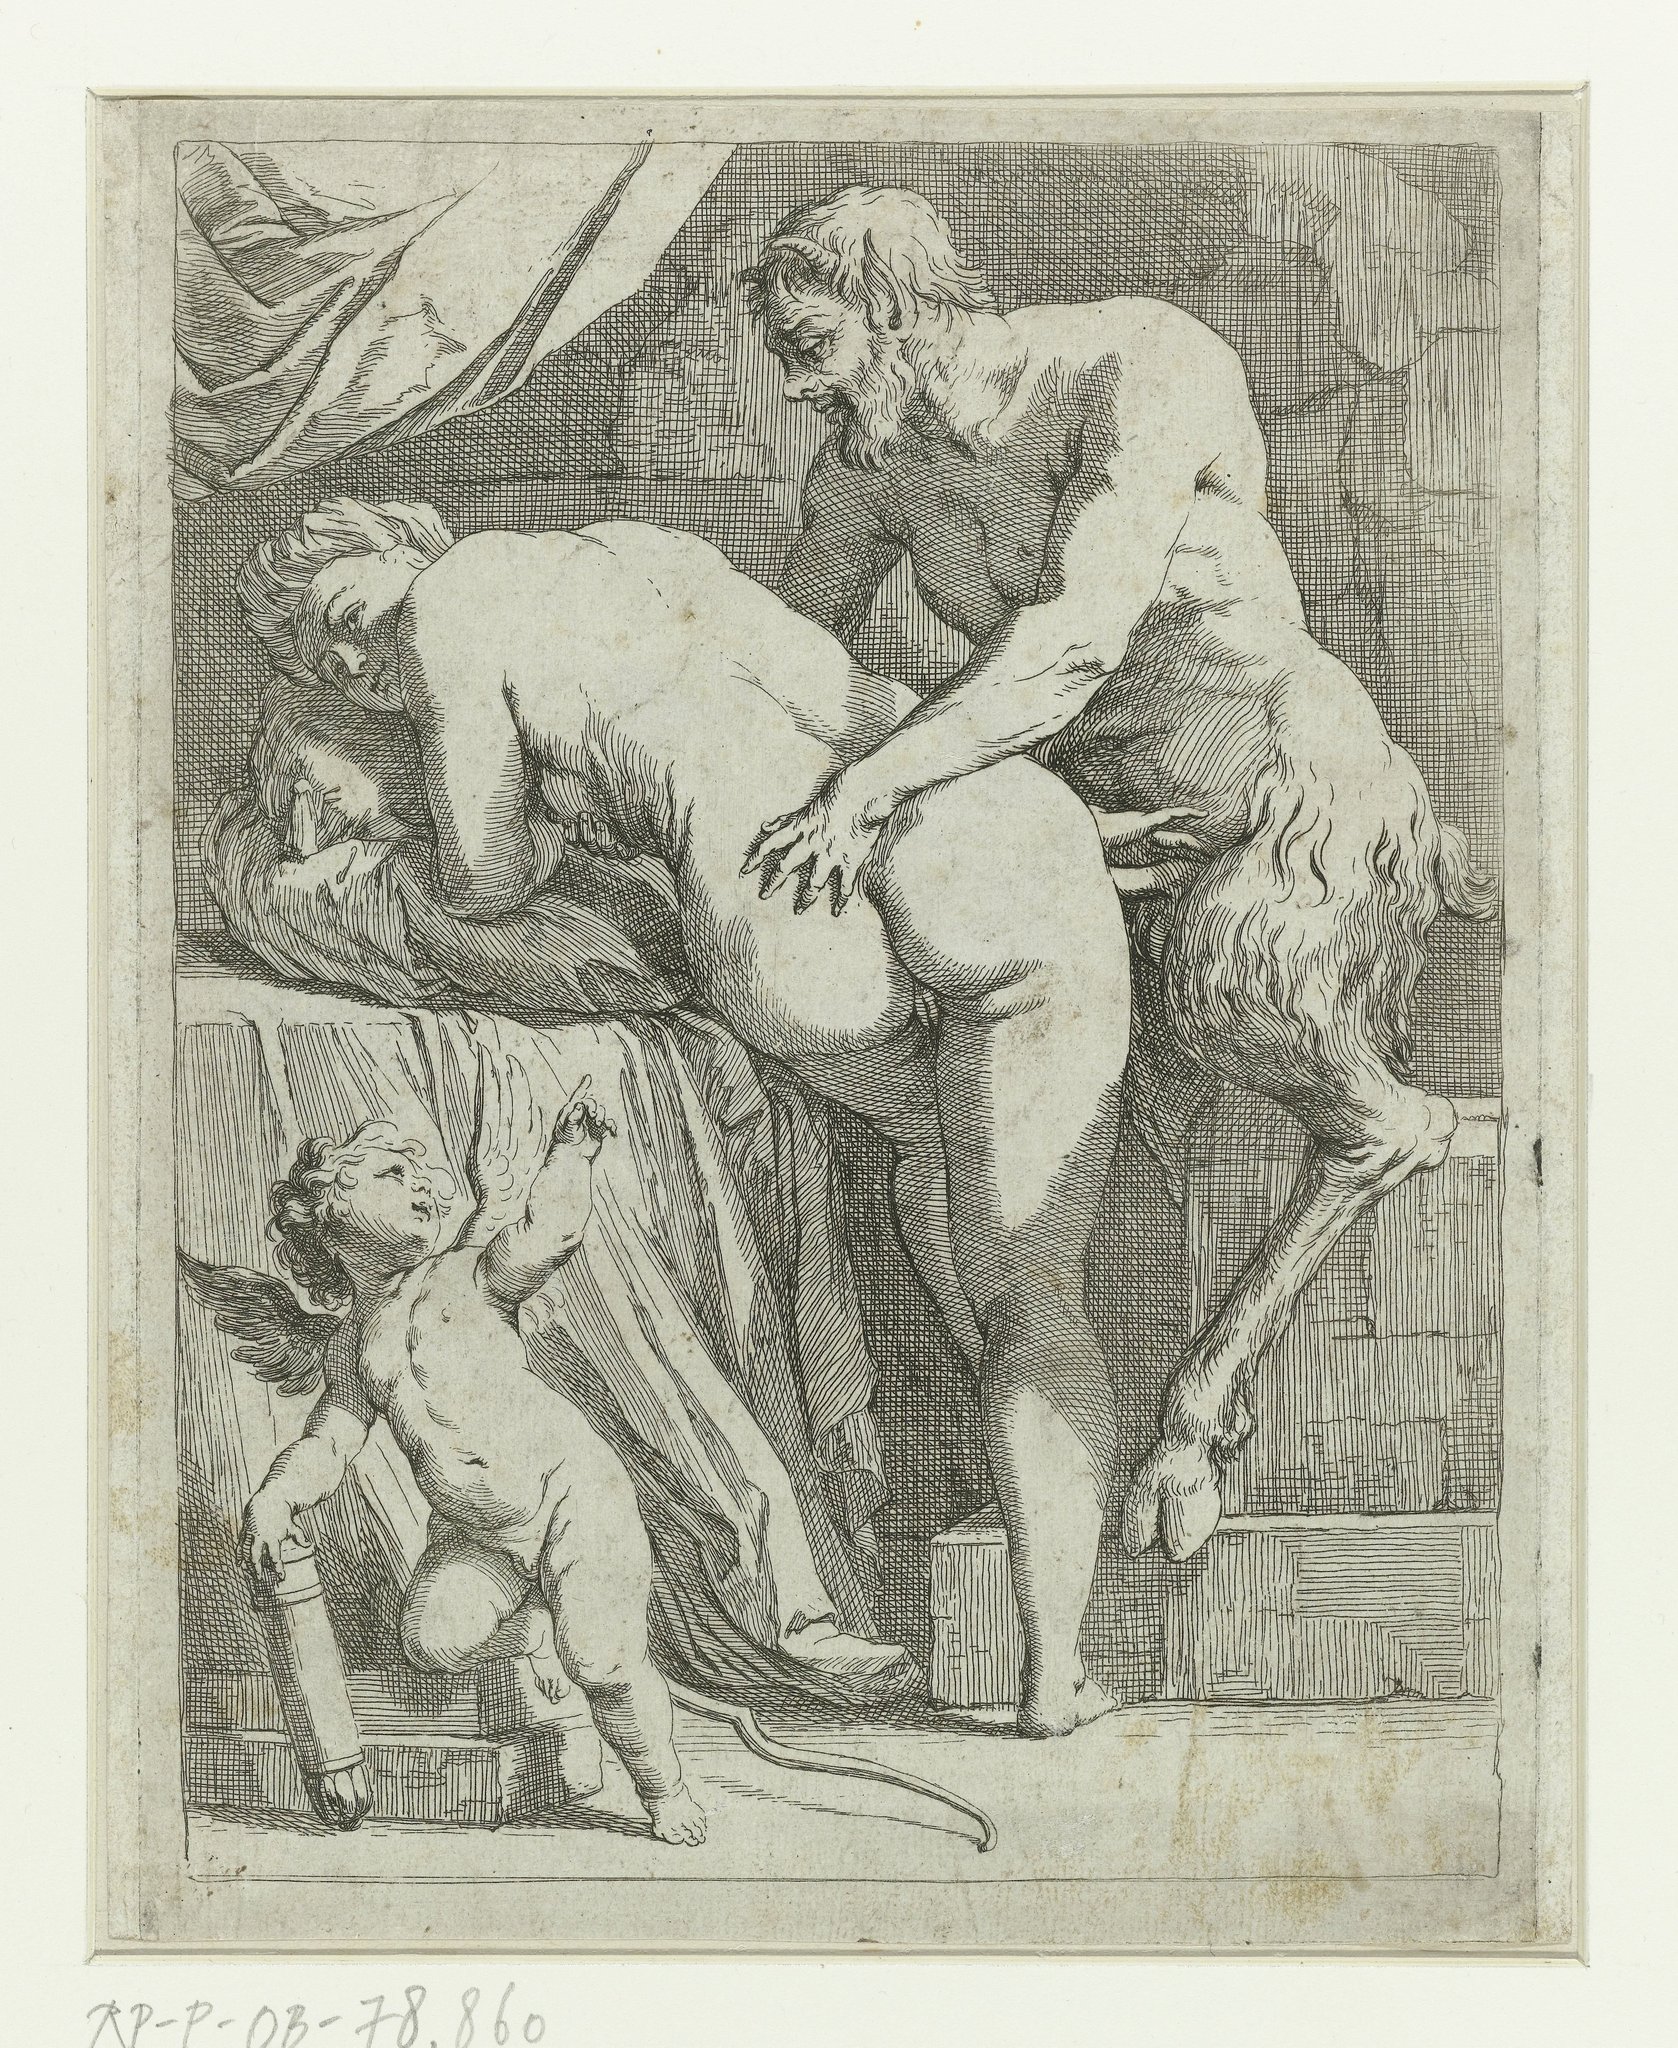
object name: print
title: Naakte vrouw met sater en Amor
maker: nicolaas verkolje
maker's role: draughtsman, painter, print maker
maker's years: 1673-1746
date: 1650-1750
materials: paper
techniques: etching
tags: sexual organs (human), satyr(s) (in general)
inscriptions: collector's mark: Lugt 240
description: Erotische scene met naakte vrouw en sater die elkaar betasten. Links op de voorgrond Amor met pijlenkoker en boog.